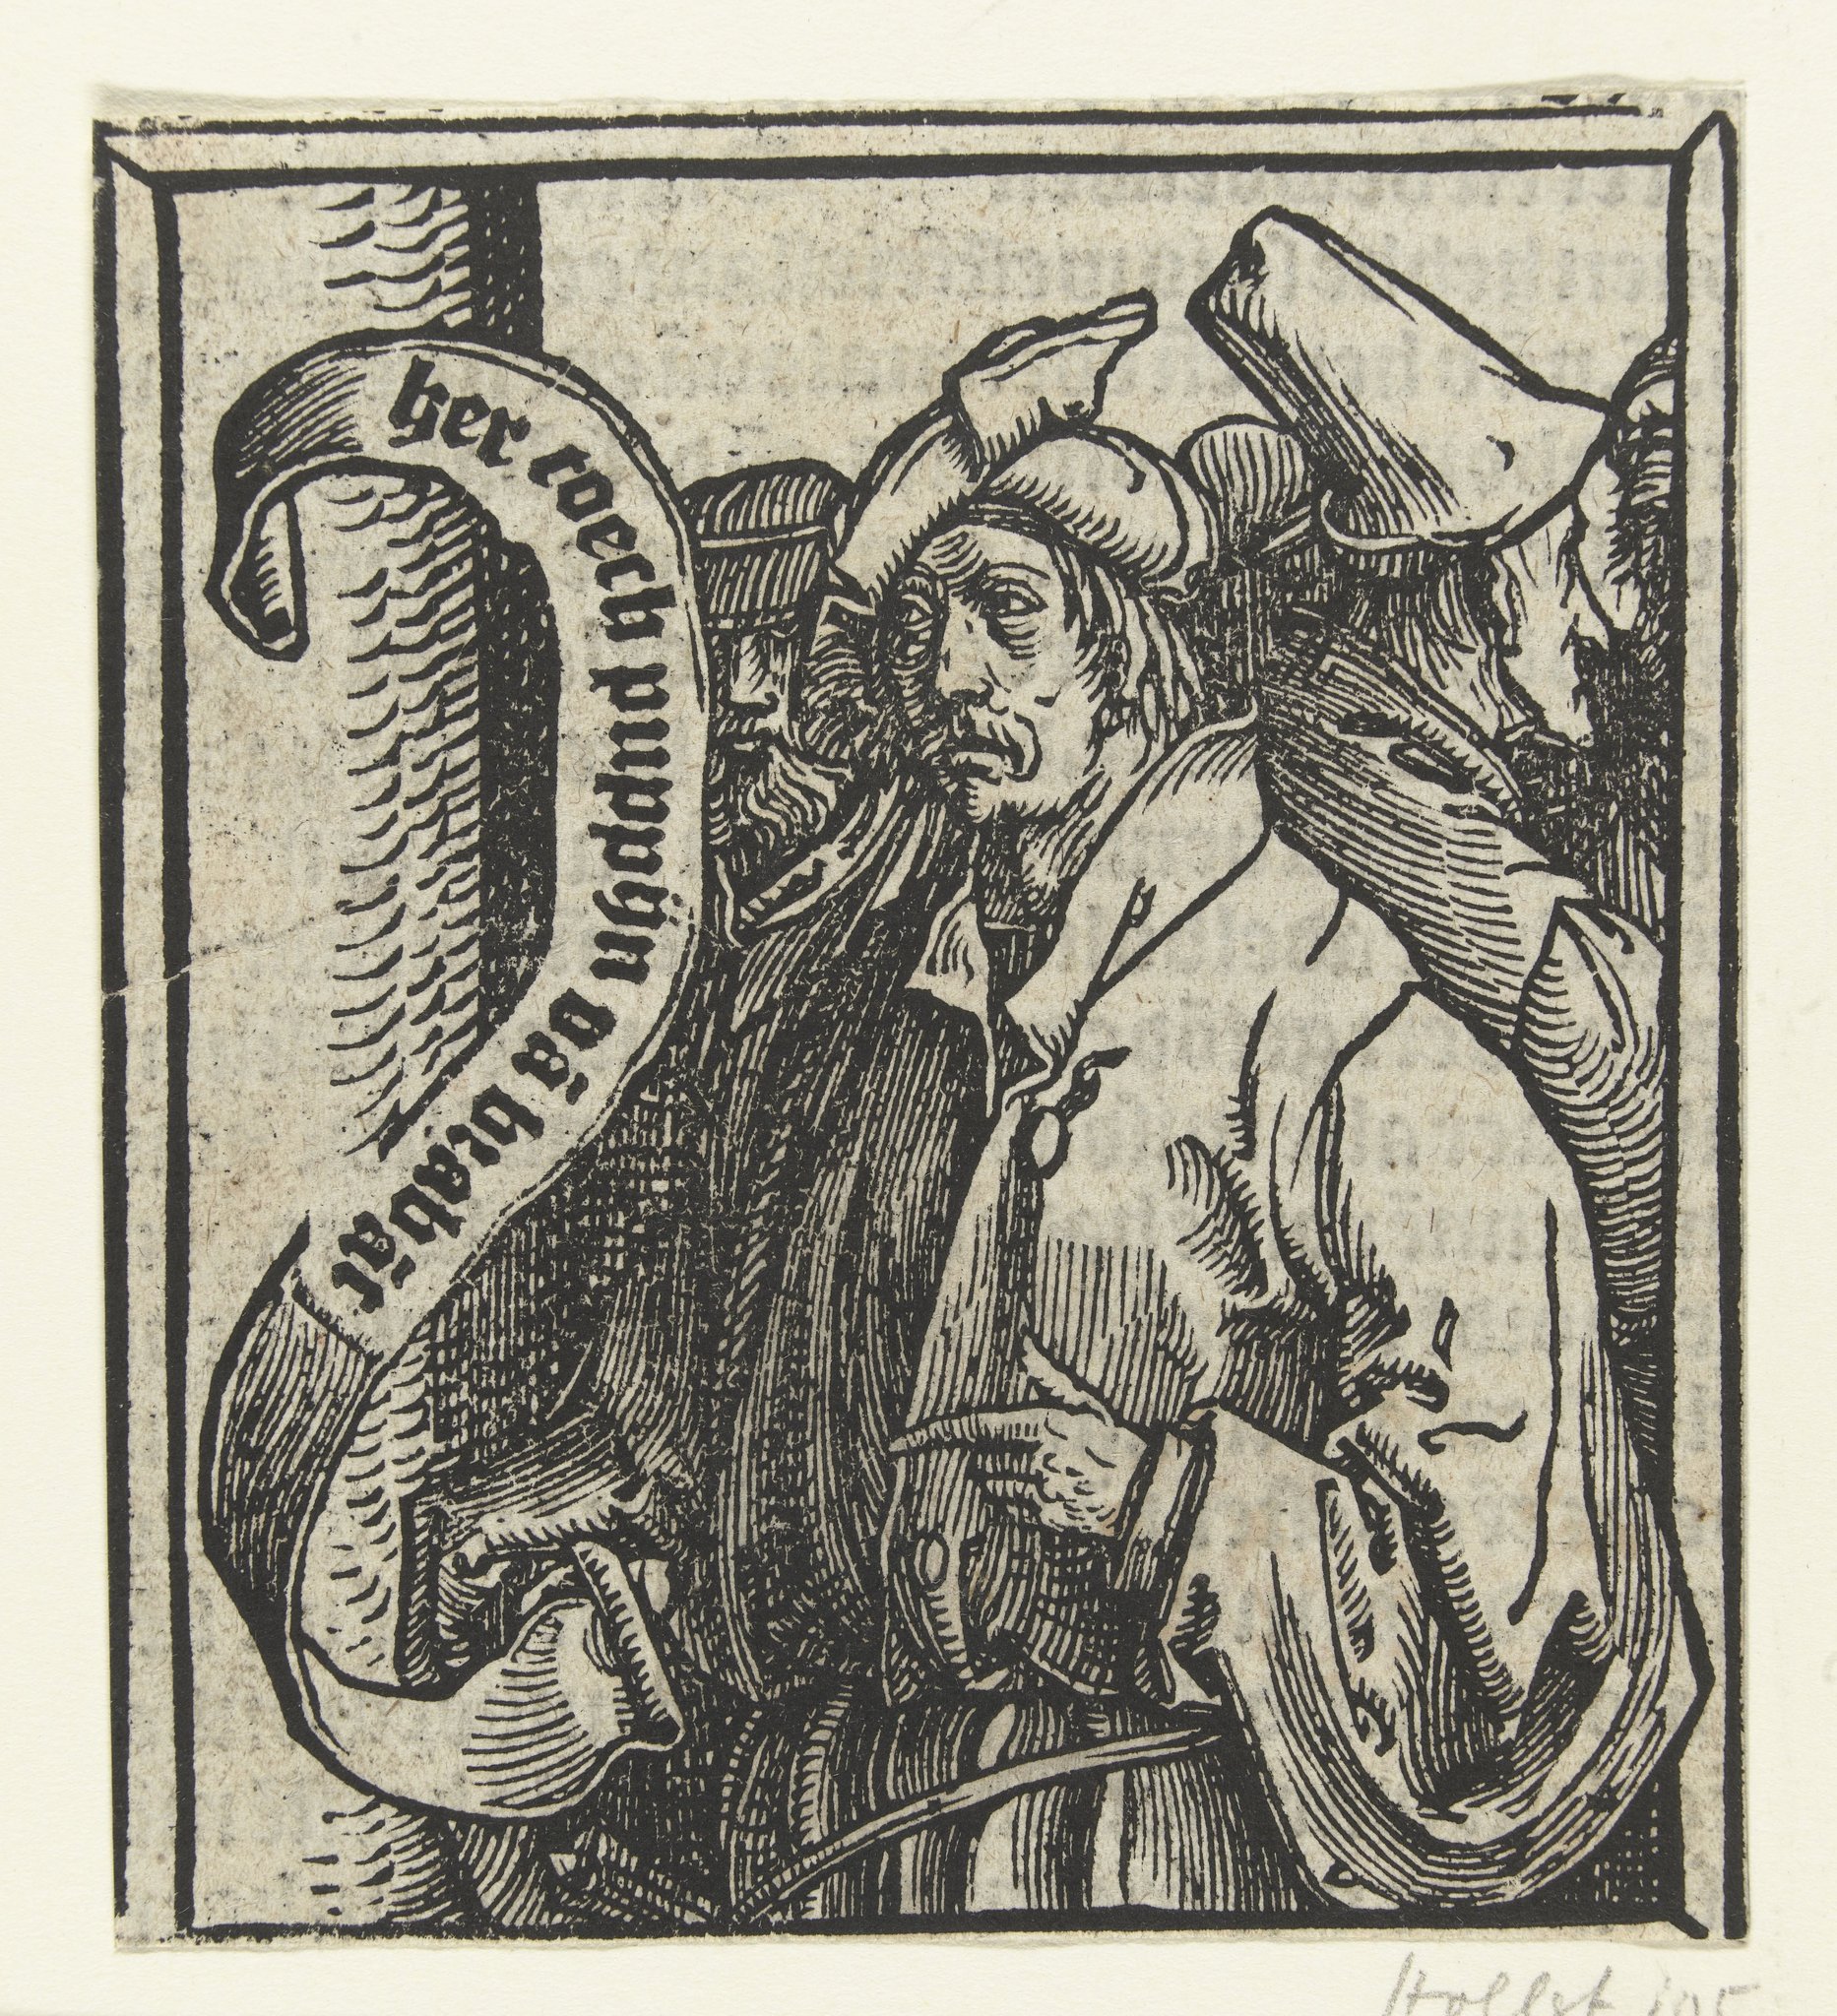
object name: book illustration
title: Portret van hertog Pepijn van Brabant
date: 1513-1517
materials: paper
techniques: woodcut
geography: low countries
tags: historical persons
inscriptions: collector's mark: Lugt 240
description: Uit "Cronycke van Hollandt, Zeelandt ende Vrieslant", uitgegeven door Jan Seversz. te Leiden. Houtsnede gebruikt in de editie van 1517 en van 1517-1530, folio 50v.